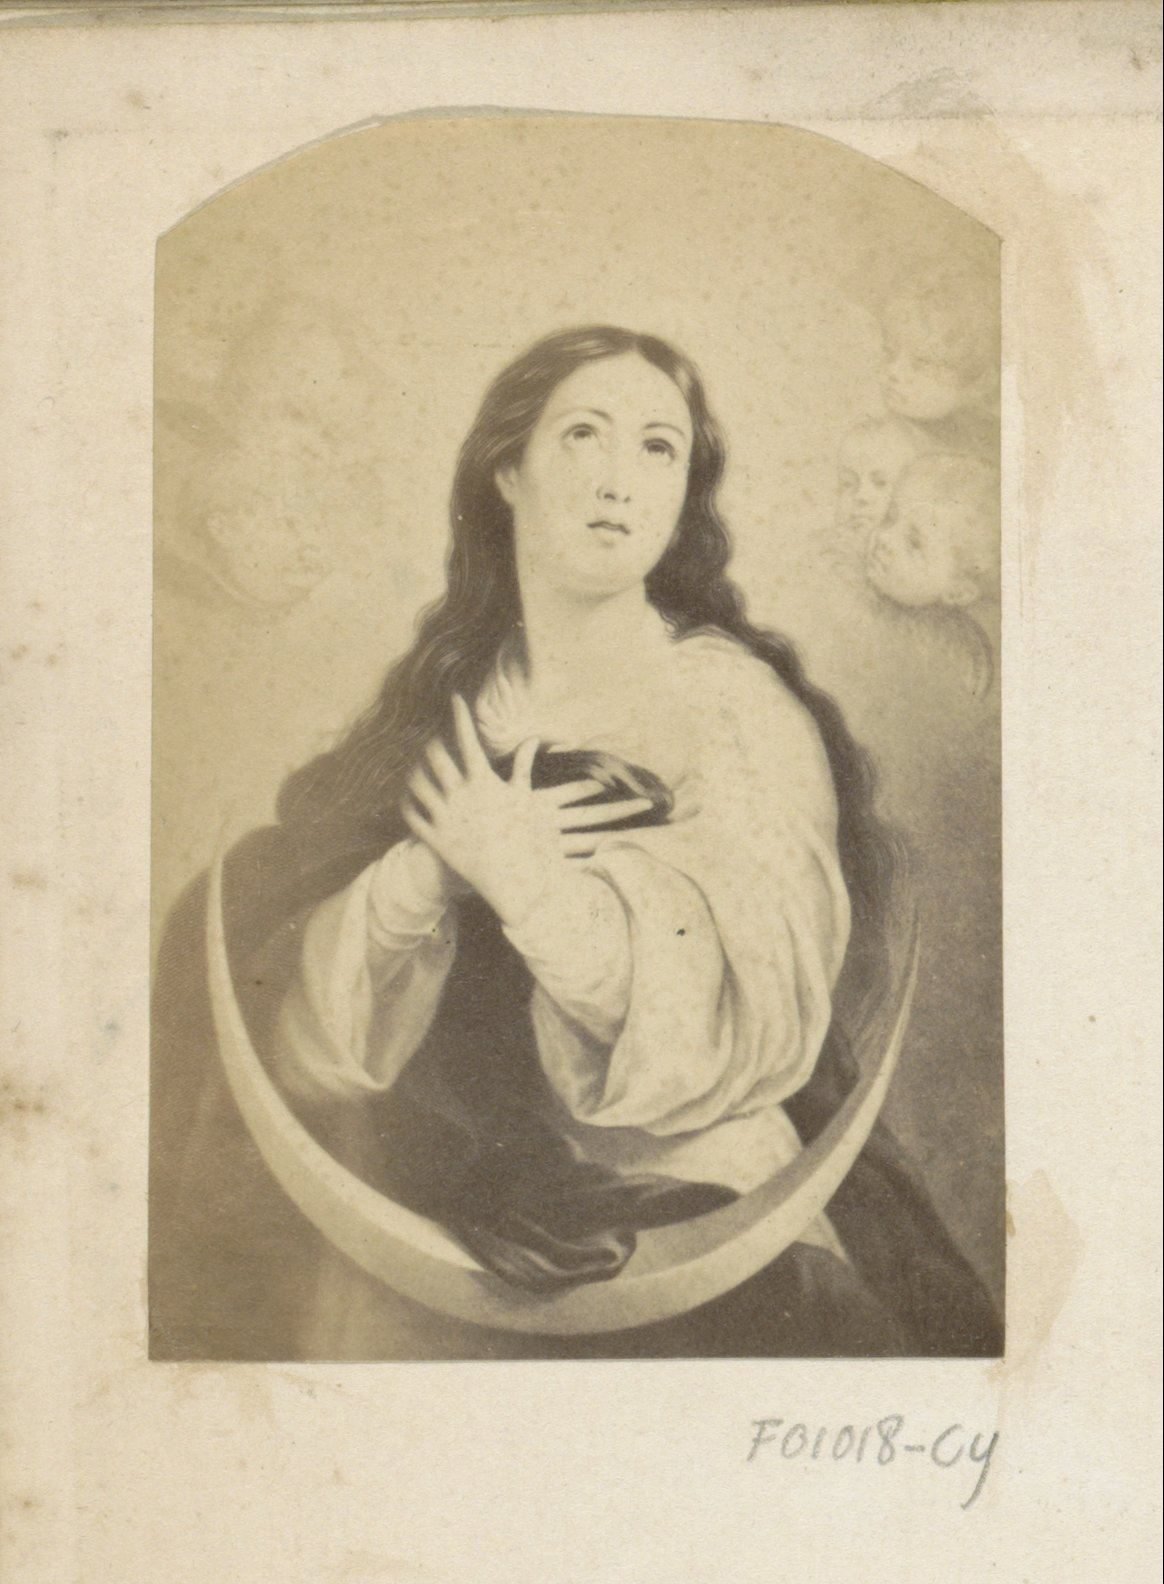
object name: photograph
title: Fotoreproductie van (vermoedelijk) een prent van een Madonna op de maansikkel omringd door engelen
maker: Anonymous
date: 1860-1870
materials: paper, photographic support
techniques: albumen print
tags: madonna on the crescent of the moon (sometimes called queen of heaven) (in mandorla), specific types of madonna with others (+ angels floating in the air)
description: Onderdeel van Engels familiealbum met foto's van personen, reizen, cricket en kunstwerken.